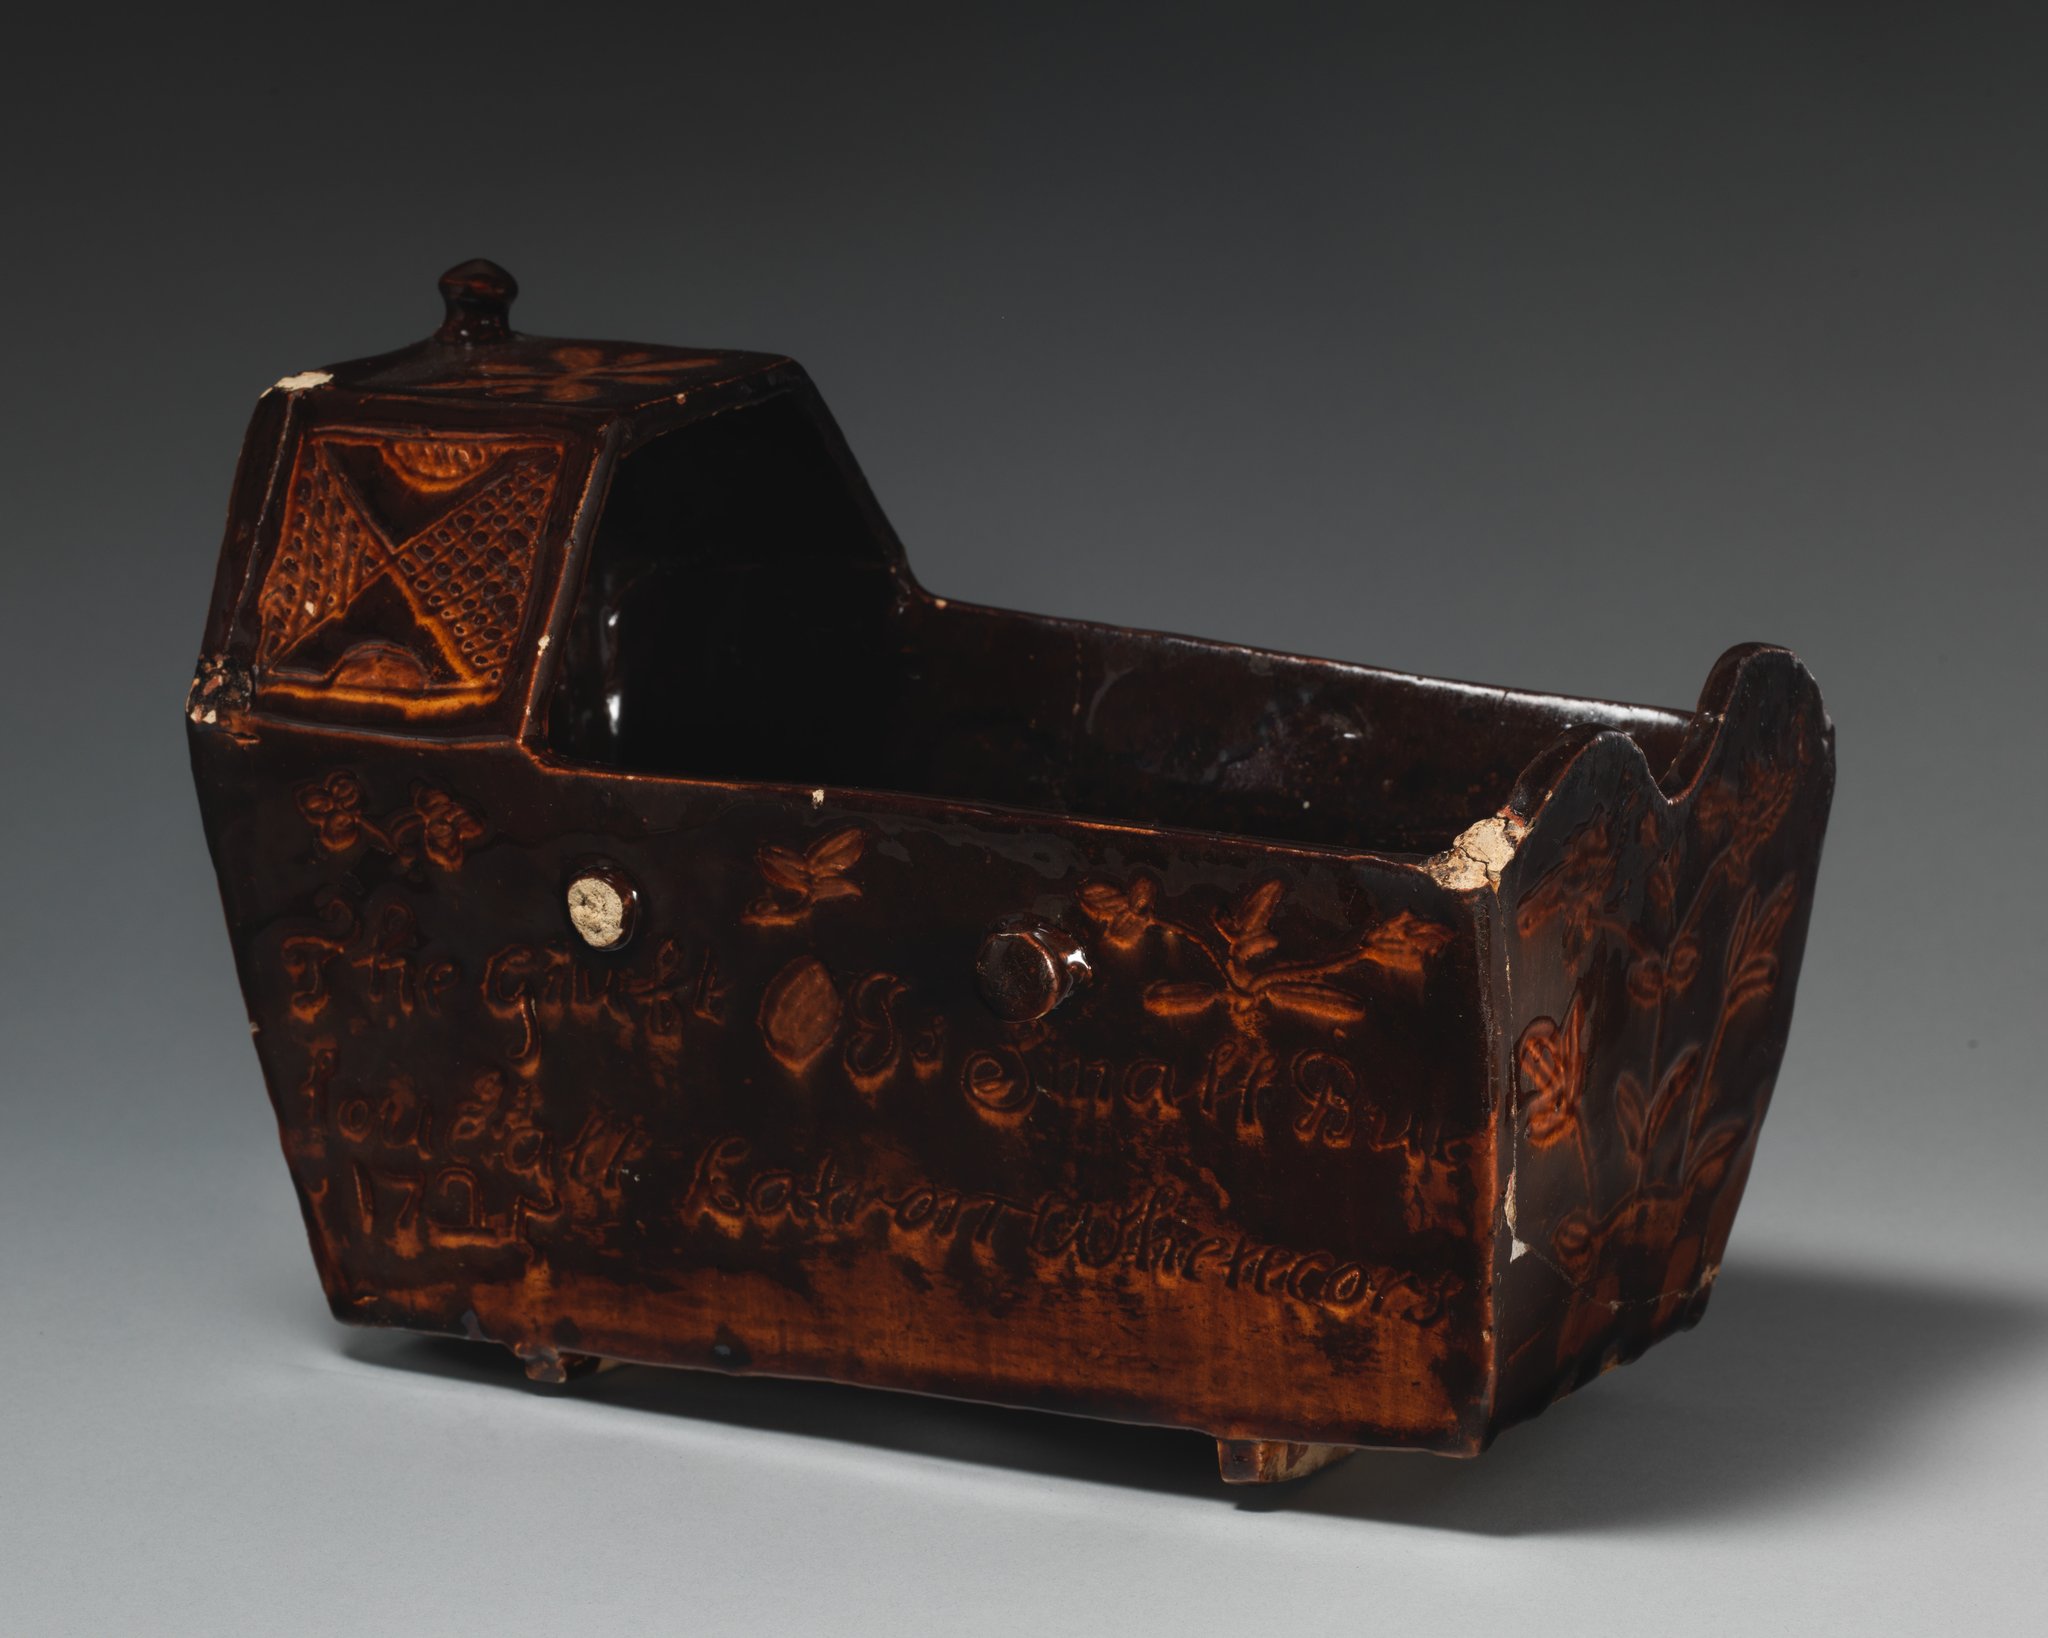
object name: cradle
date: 1701-1800